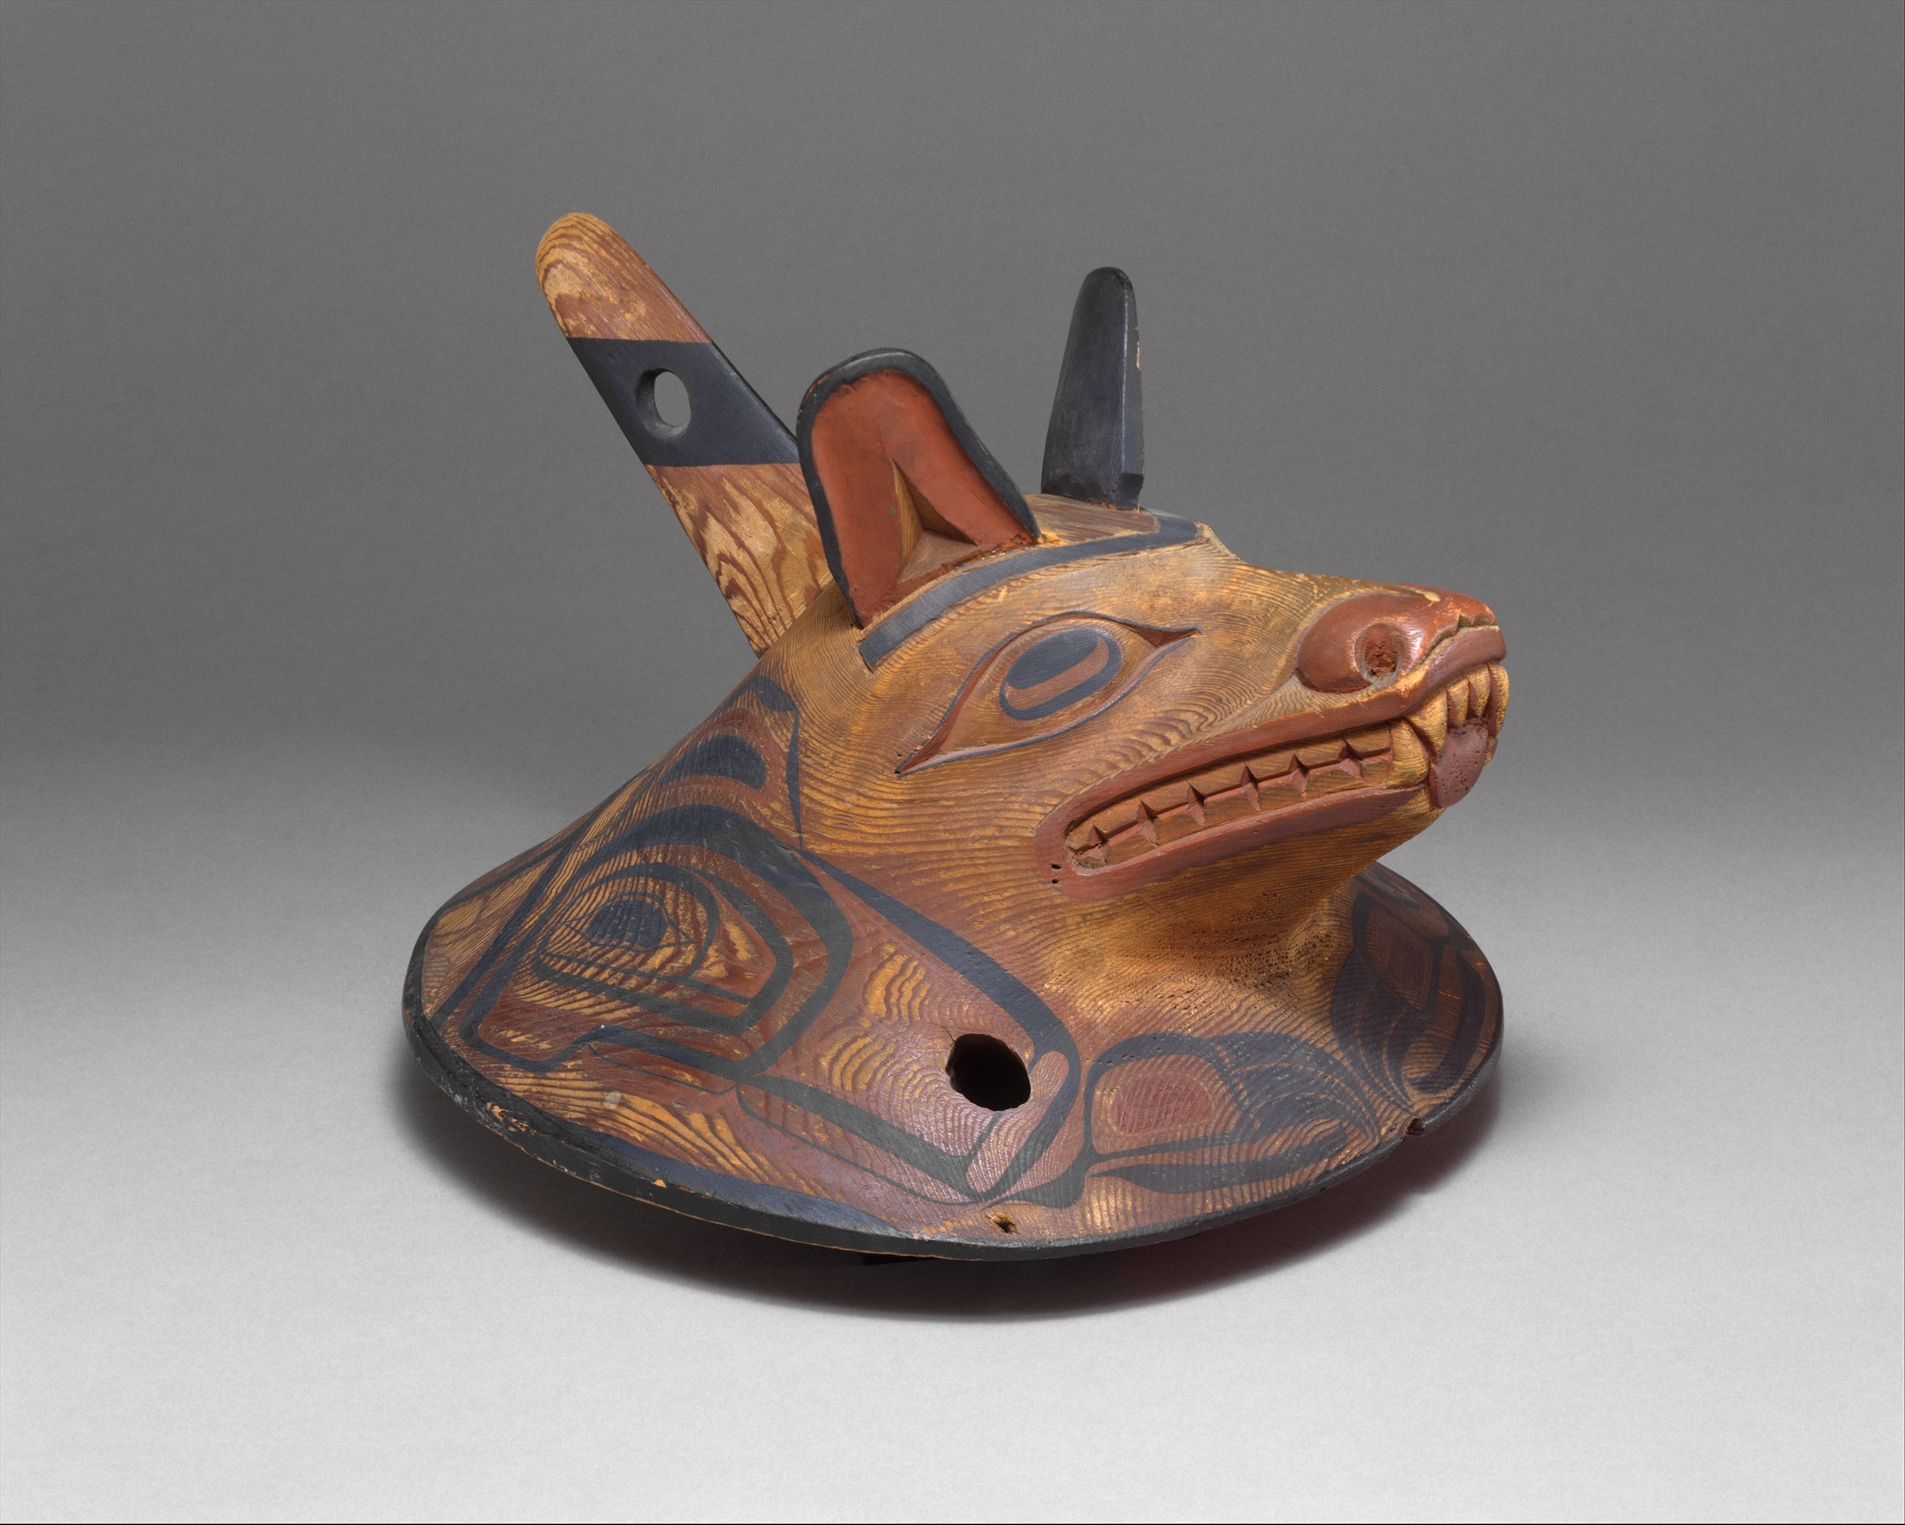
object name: helmet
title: Crest Helmet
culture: haida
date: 1860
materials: pigment, wood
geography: canada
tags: animals,helmets